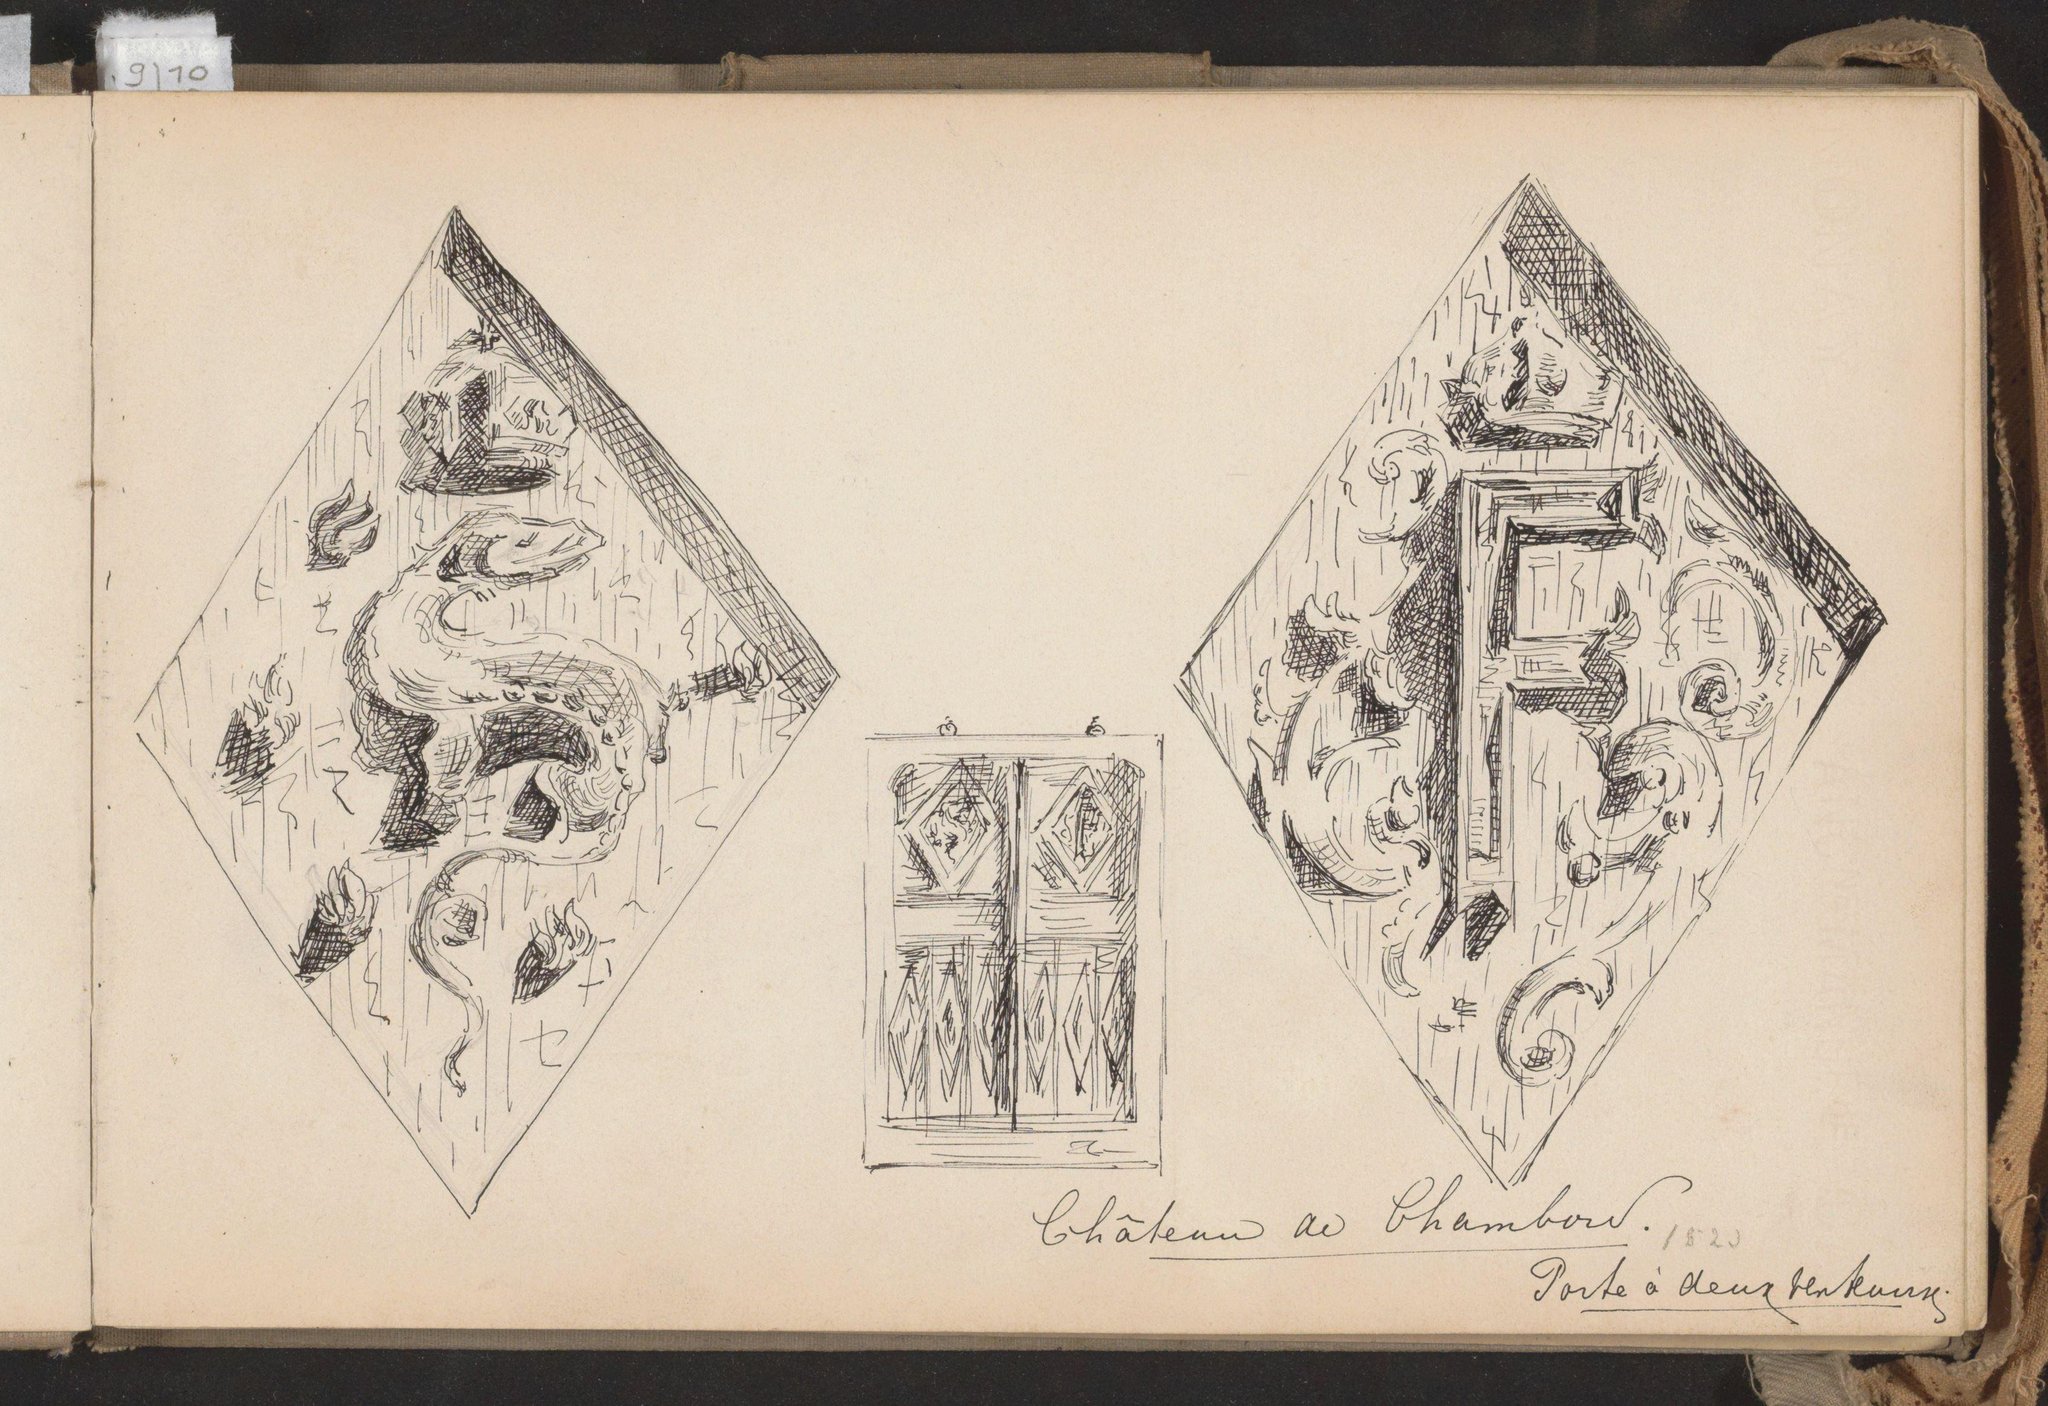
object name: sketchbook leaf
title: Architectuurdetails van het Château de Chambord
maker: johanna van de kamer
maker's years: 1873-1922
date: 1890-1922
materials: ink, paper, pencil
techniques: pen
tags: architectural detail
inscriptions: annotation: ‘Château de Chambord/ 1523/ Porte à deux [...]’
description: Blad 7 recto uit een schetsboek met 49 bladen.